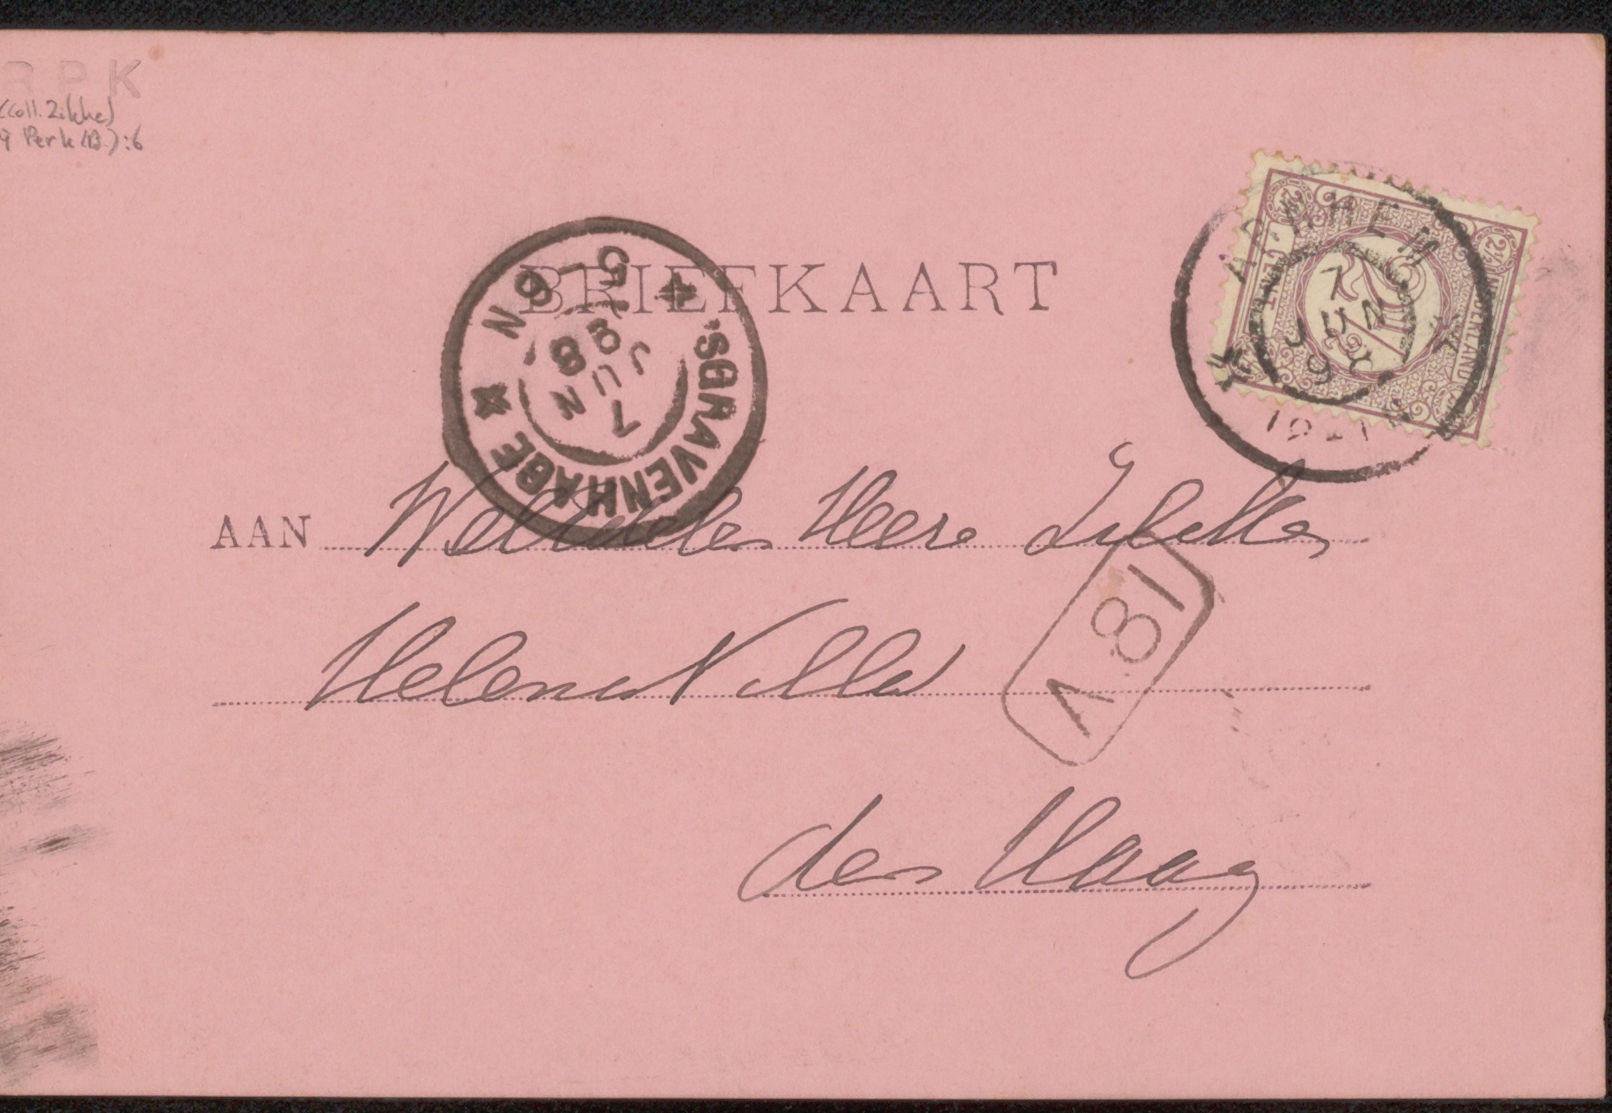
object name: postcard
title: Briefkaart aan Philip Zilcken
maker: christina elizabeth perk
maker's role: painter, sculptor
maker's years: 1833-1906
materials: cardboard, ink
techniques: pen, writing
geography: arnhem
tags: draughtsman, philip zilcken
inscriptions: collector's mark: ‘RPK’